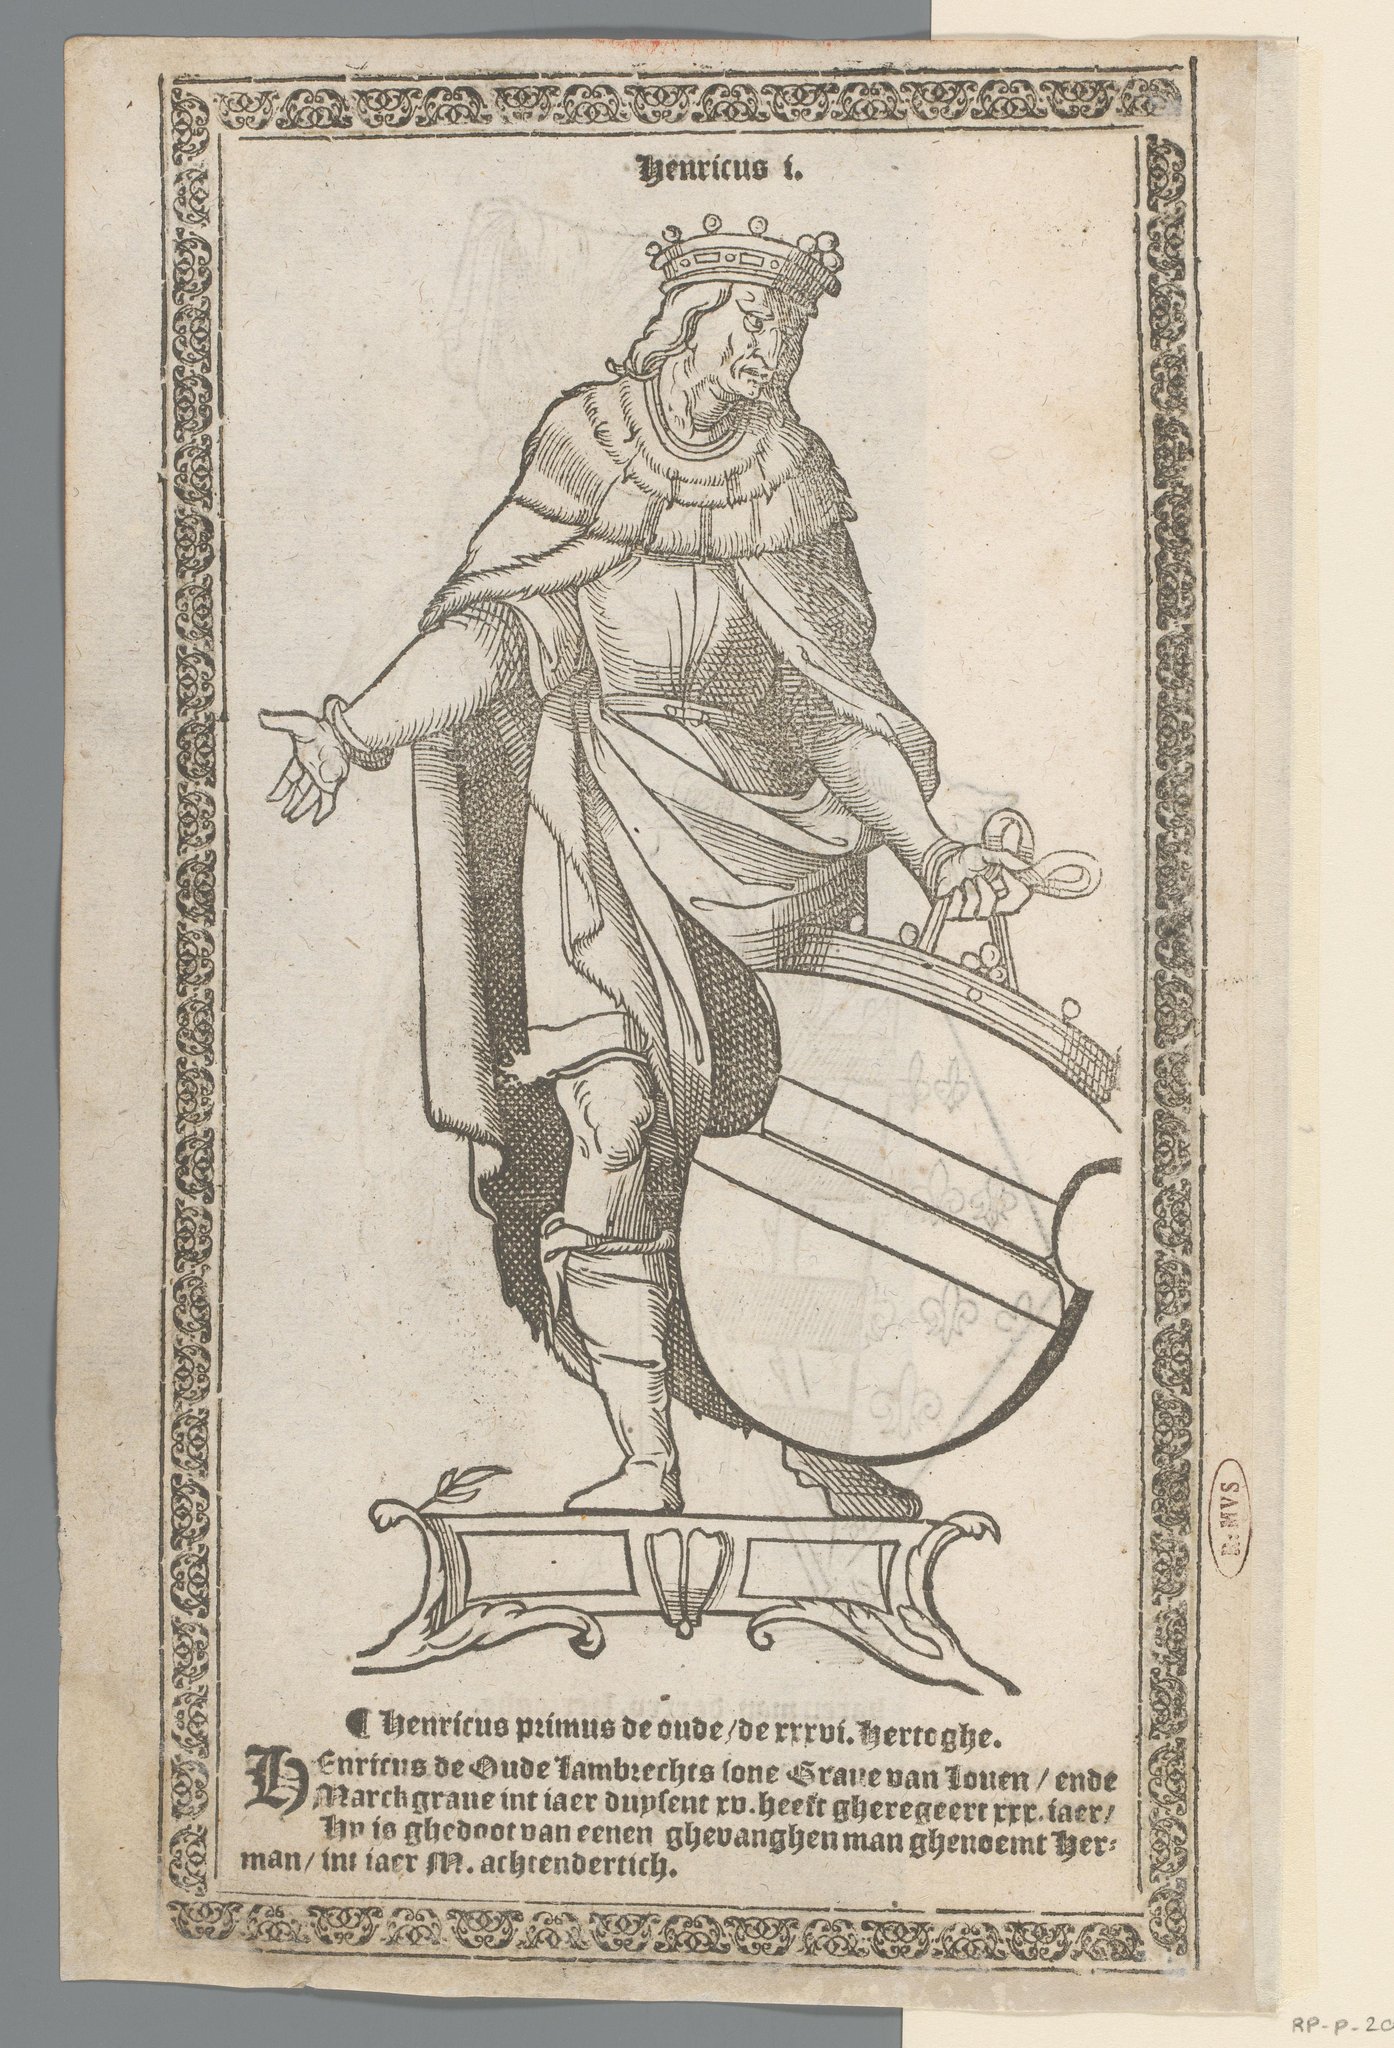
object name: print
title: Portret van Hendrik I, graaf van Leuven en Brussel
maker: jan molijns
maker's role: print maker, publisher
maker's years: 1498-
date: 1565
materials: paper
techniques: letterpress printing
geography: antwerp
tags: brussels, historical persons, armorial bearing, heraldry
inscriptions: collector's mark: Lugt 2228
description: Prent uit: Dit is die afcoemste ende genalogie der hertoghen ende hertoginnen van Brabandt, (...). Antwerpen: Jan Molijns, 1565.